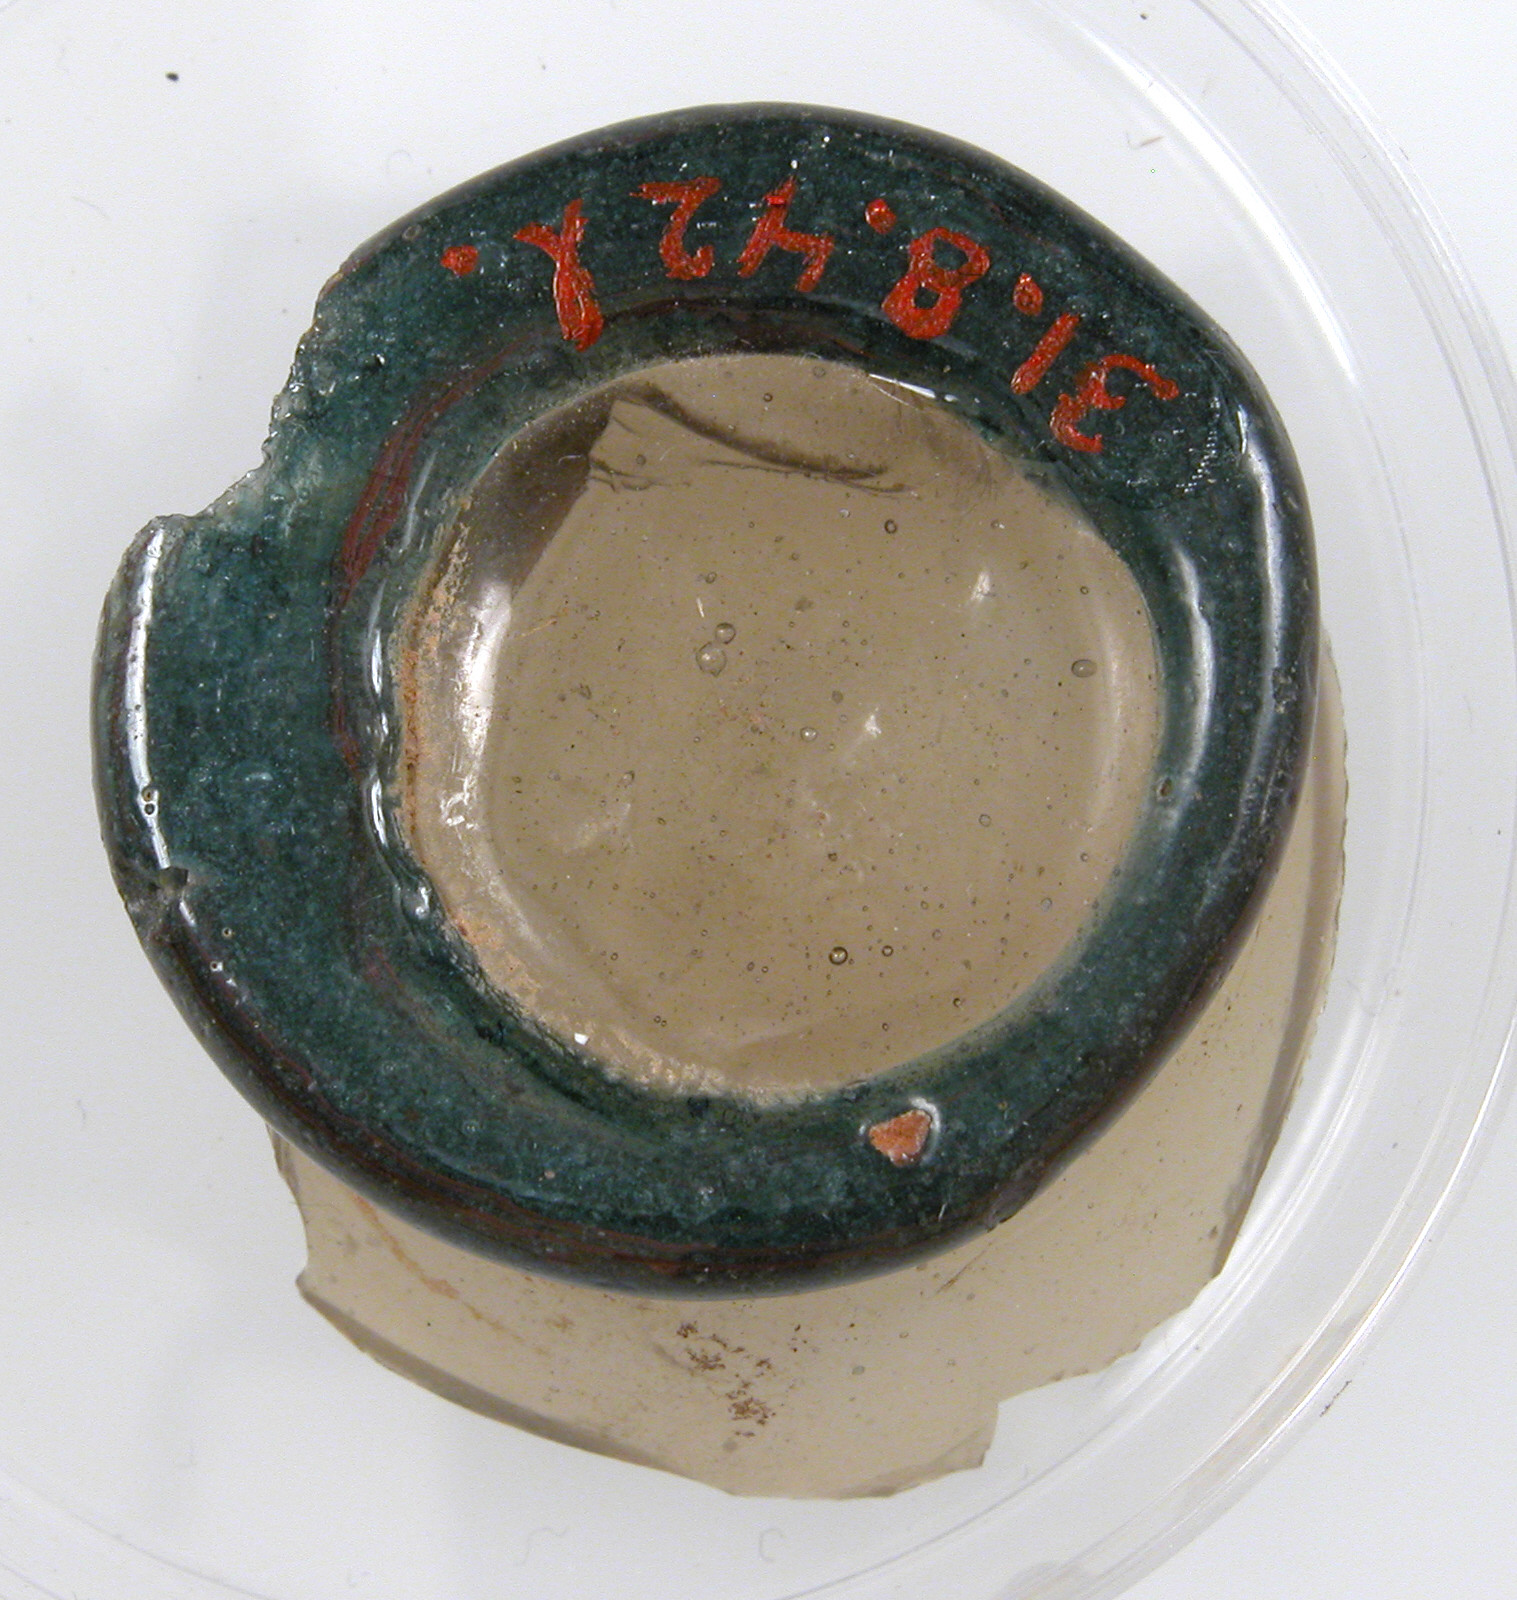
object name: fragment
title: Foot of a Vessel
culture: coptic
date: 301-400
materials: glass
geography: egypt